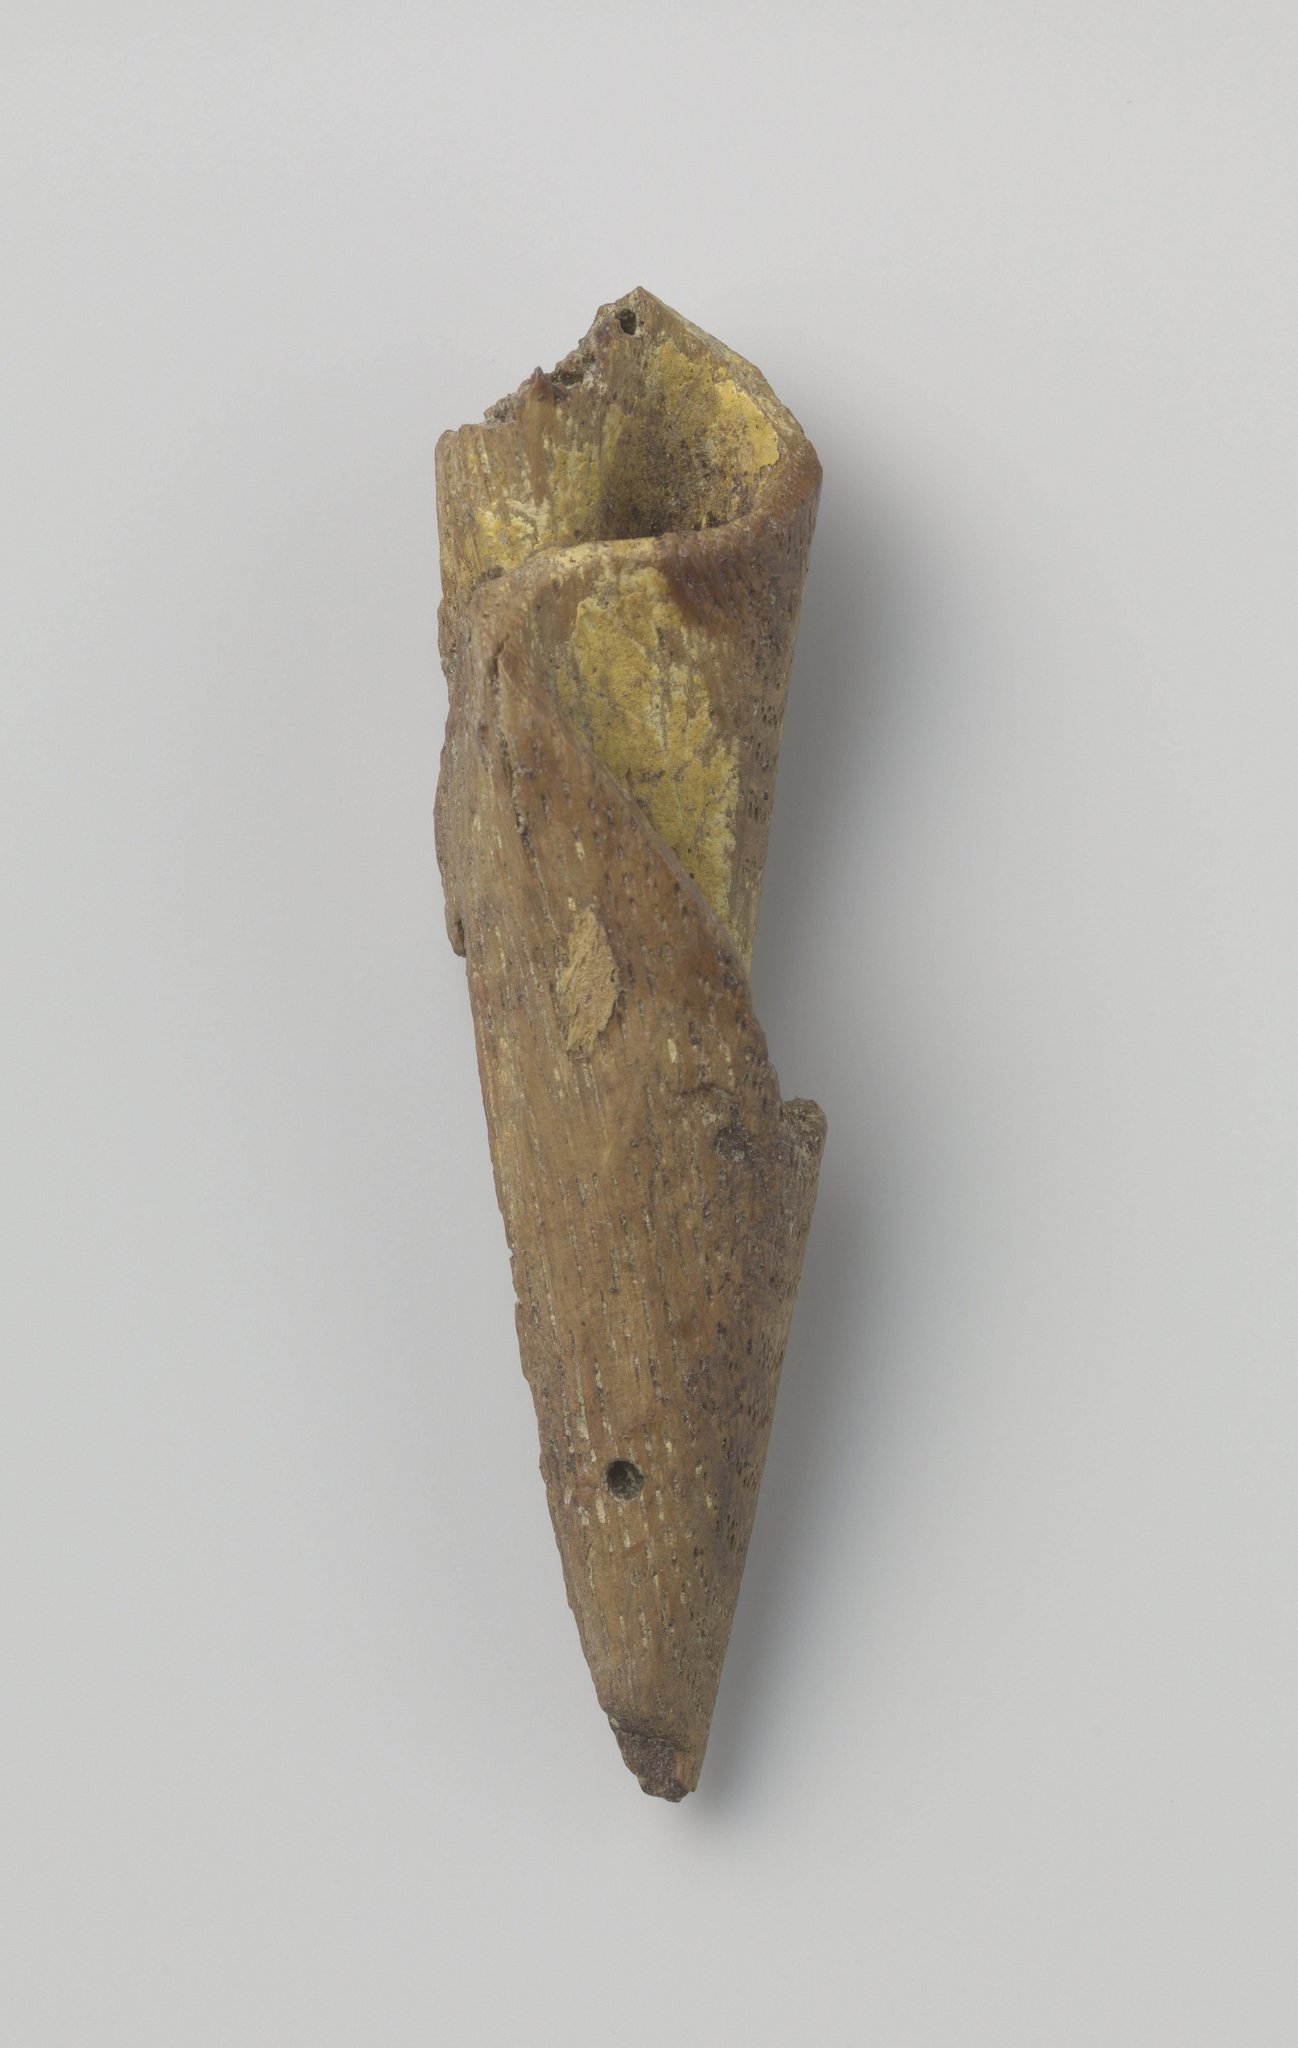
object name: fragment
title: Fragment (plooi van een gewaad?); (mogelijk) behorend tot het retabel van Soest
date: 1475-1499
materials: wood